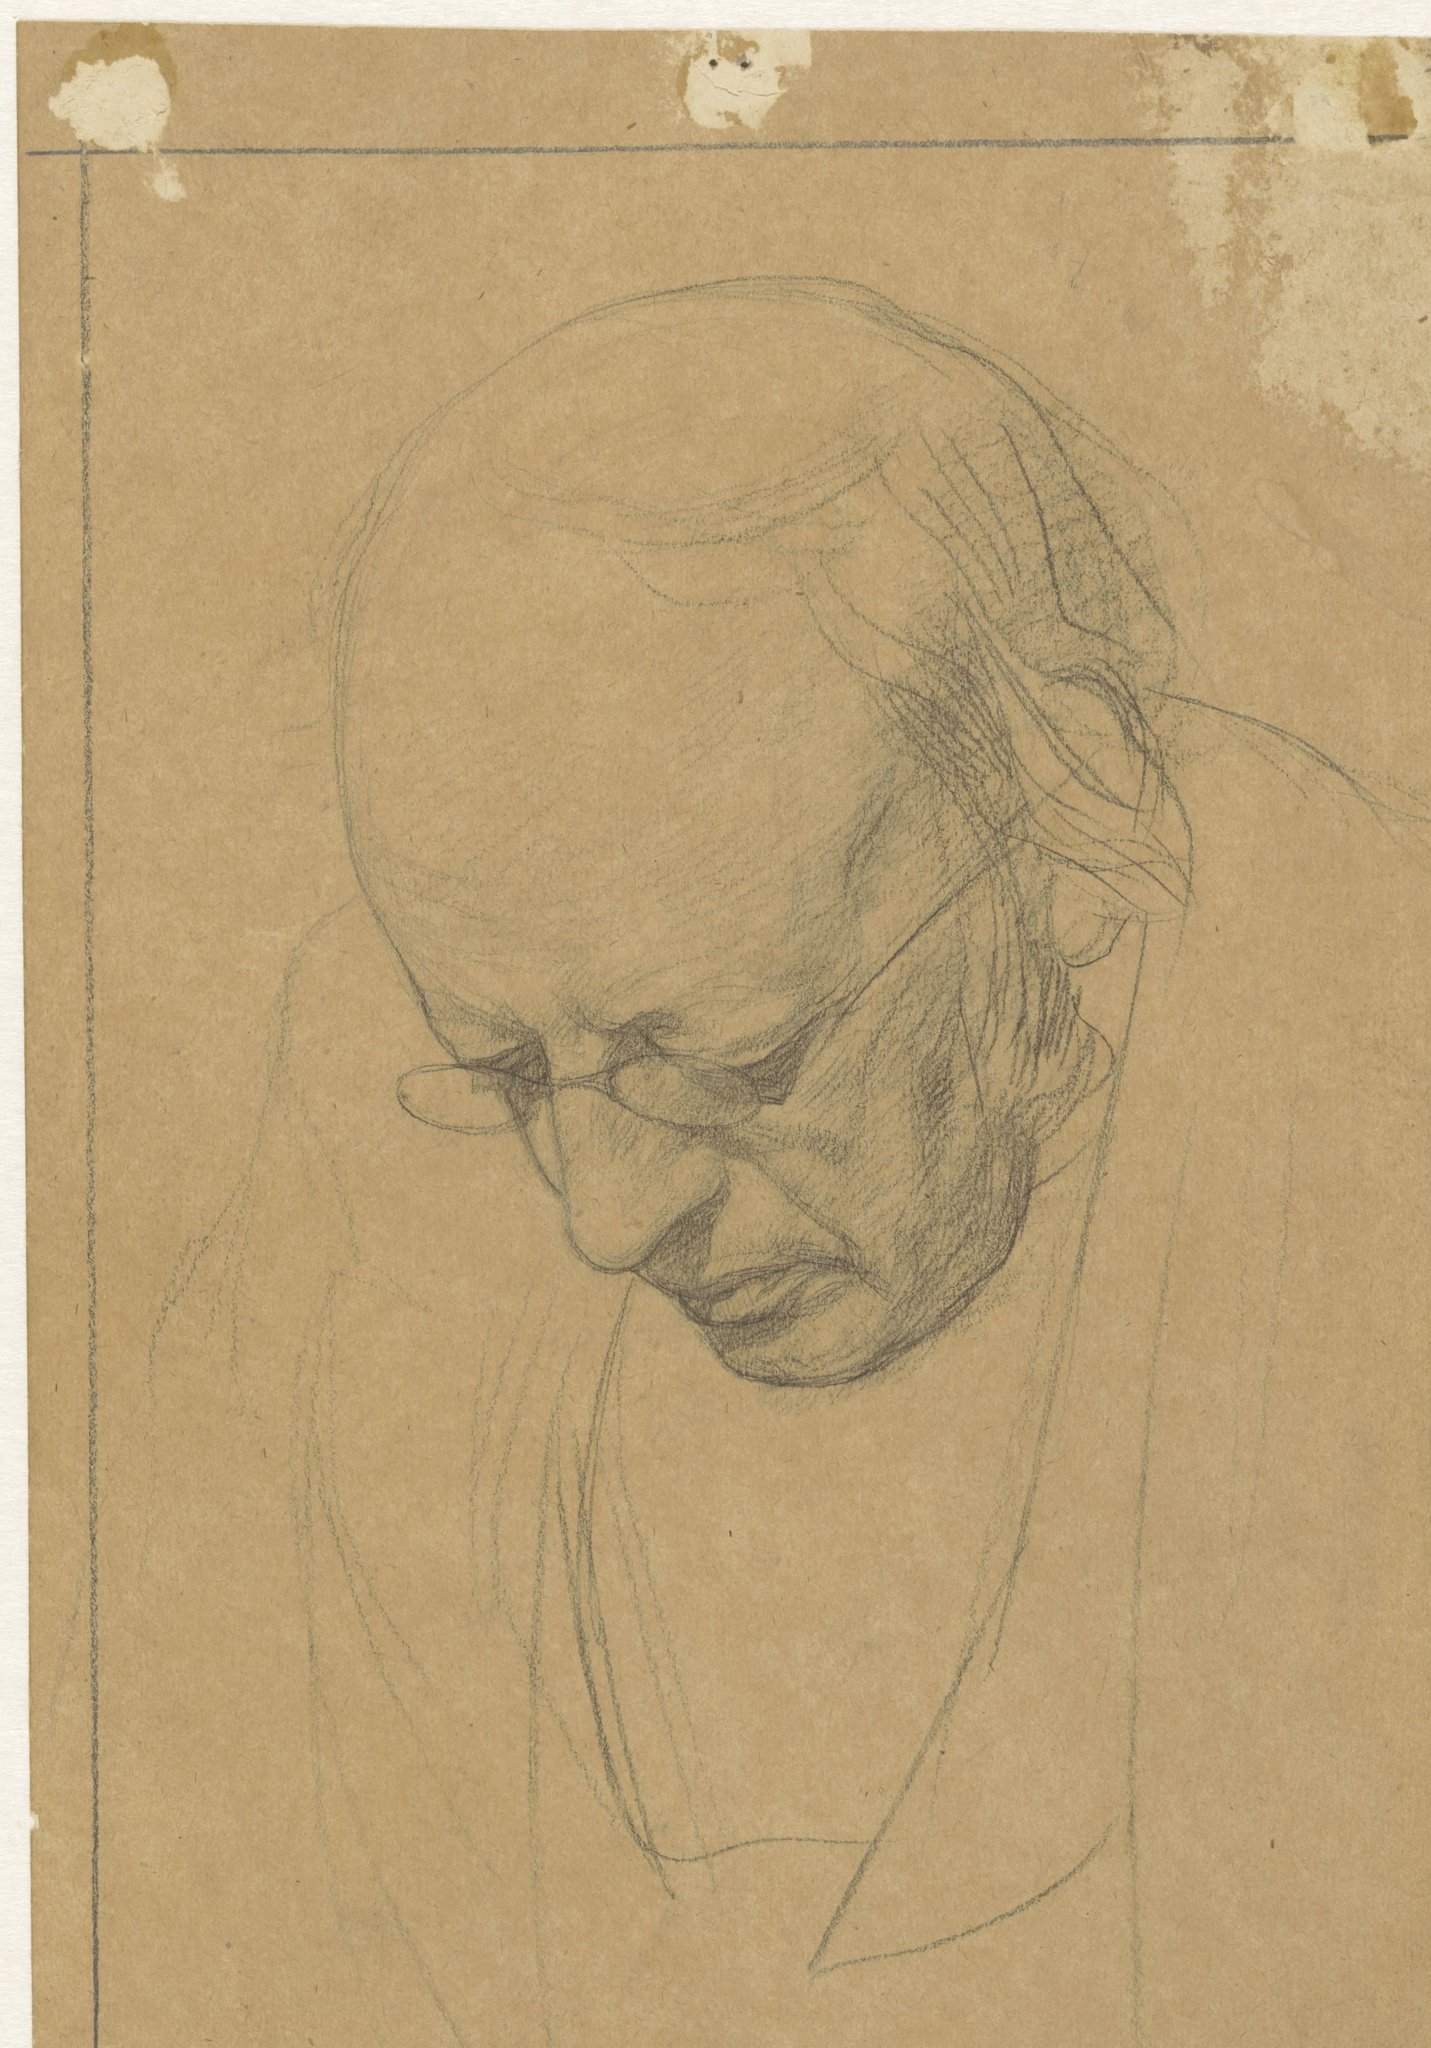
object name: drawing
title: Portret van Gerrardus Huibert Veth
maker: jan veth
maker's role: designer, draughtsman, painter, print maker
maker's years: 1864-1925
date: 1884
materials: paper, pencil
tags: historical persons